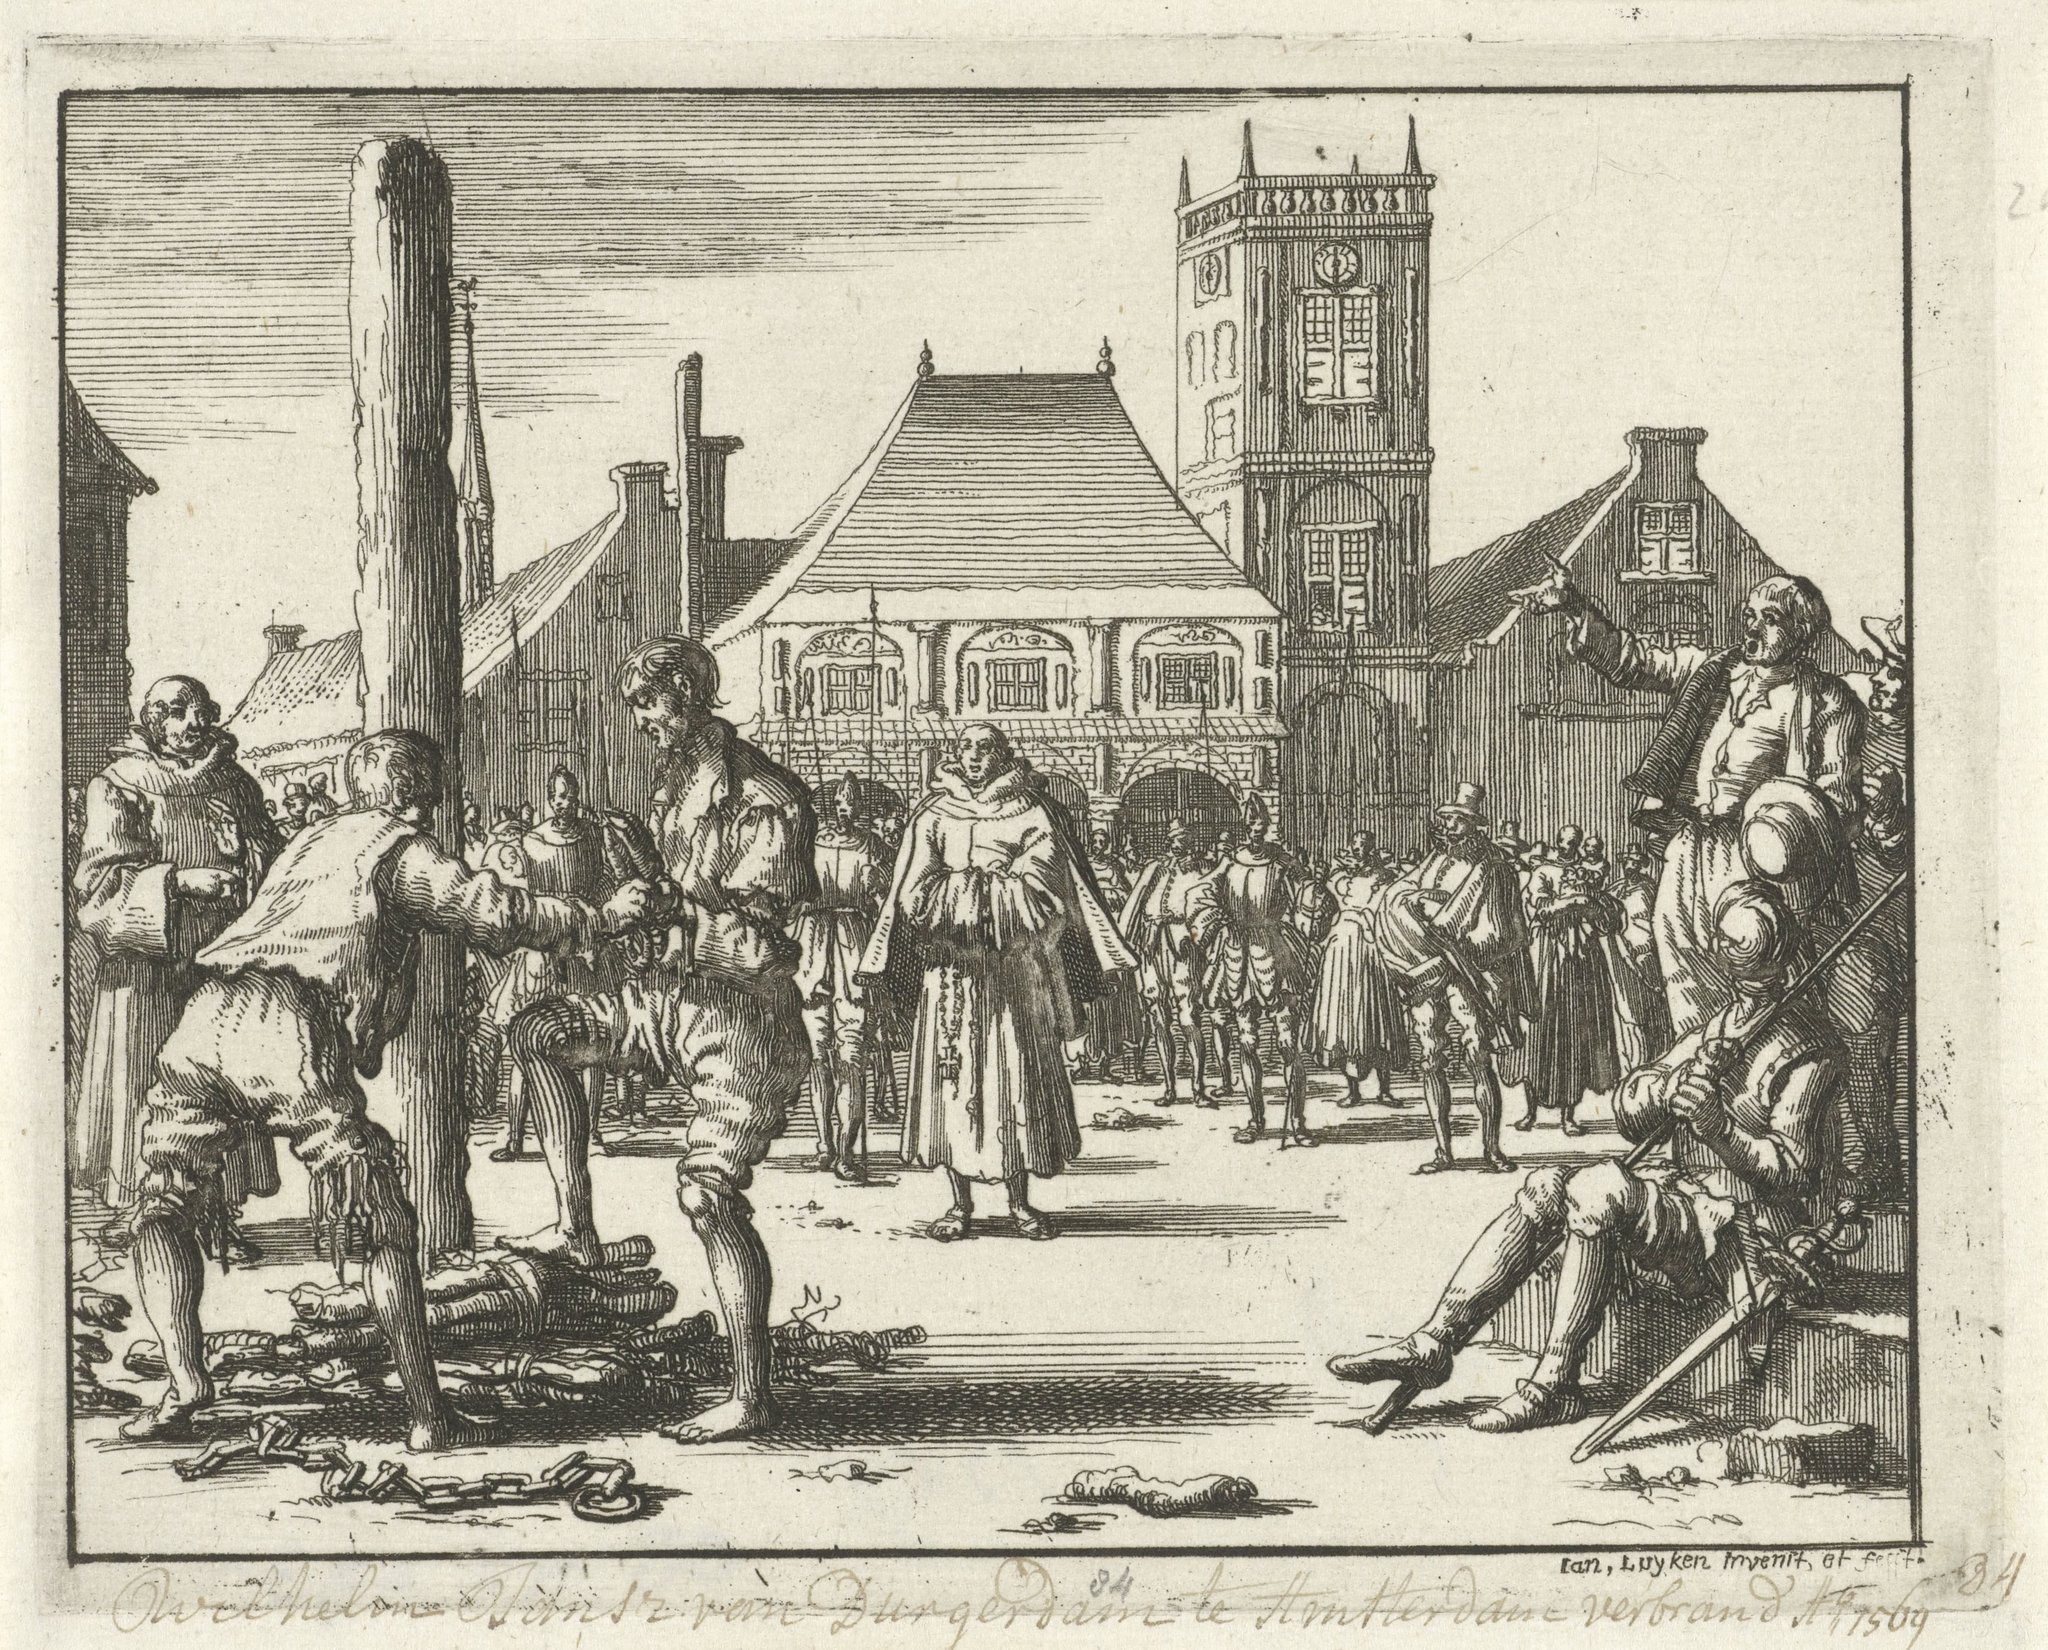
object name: book illustration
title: Willem Jansz. beklimt de brandstapel te Amsterdam, 1569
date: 1685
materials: paper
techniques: etching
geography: amsterdam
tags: violent death by burning at the stake; pyre, persecution of heretics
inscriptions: inscription: ‘Willem Jansz [...] Ao 1570’, number: ‘84’, collector's mark: Lugt 2228